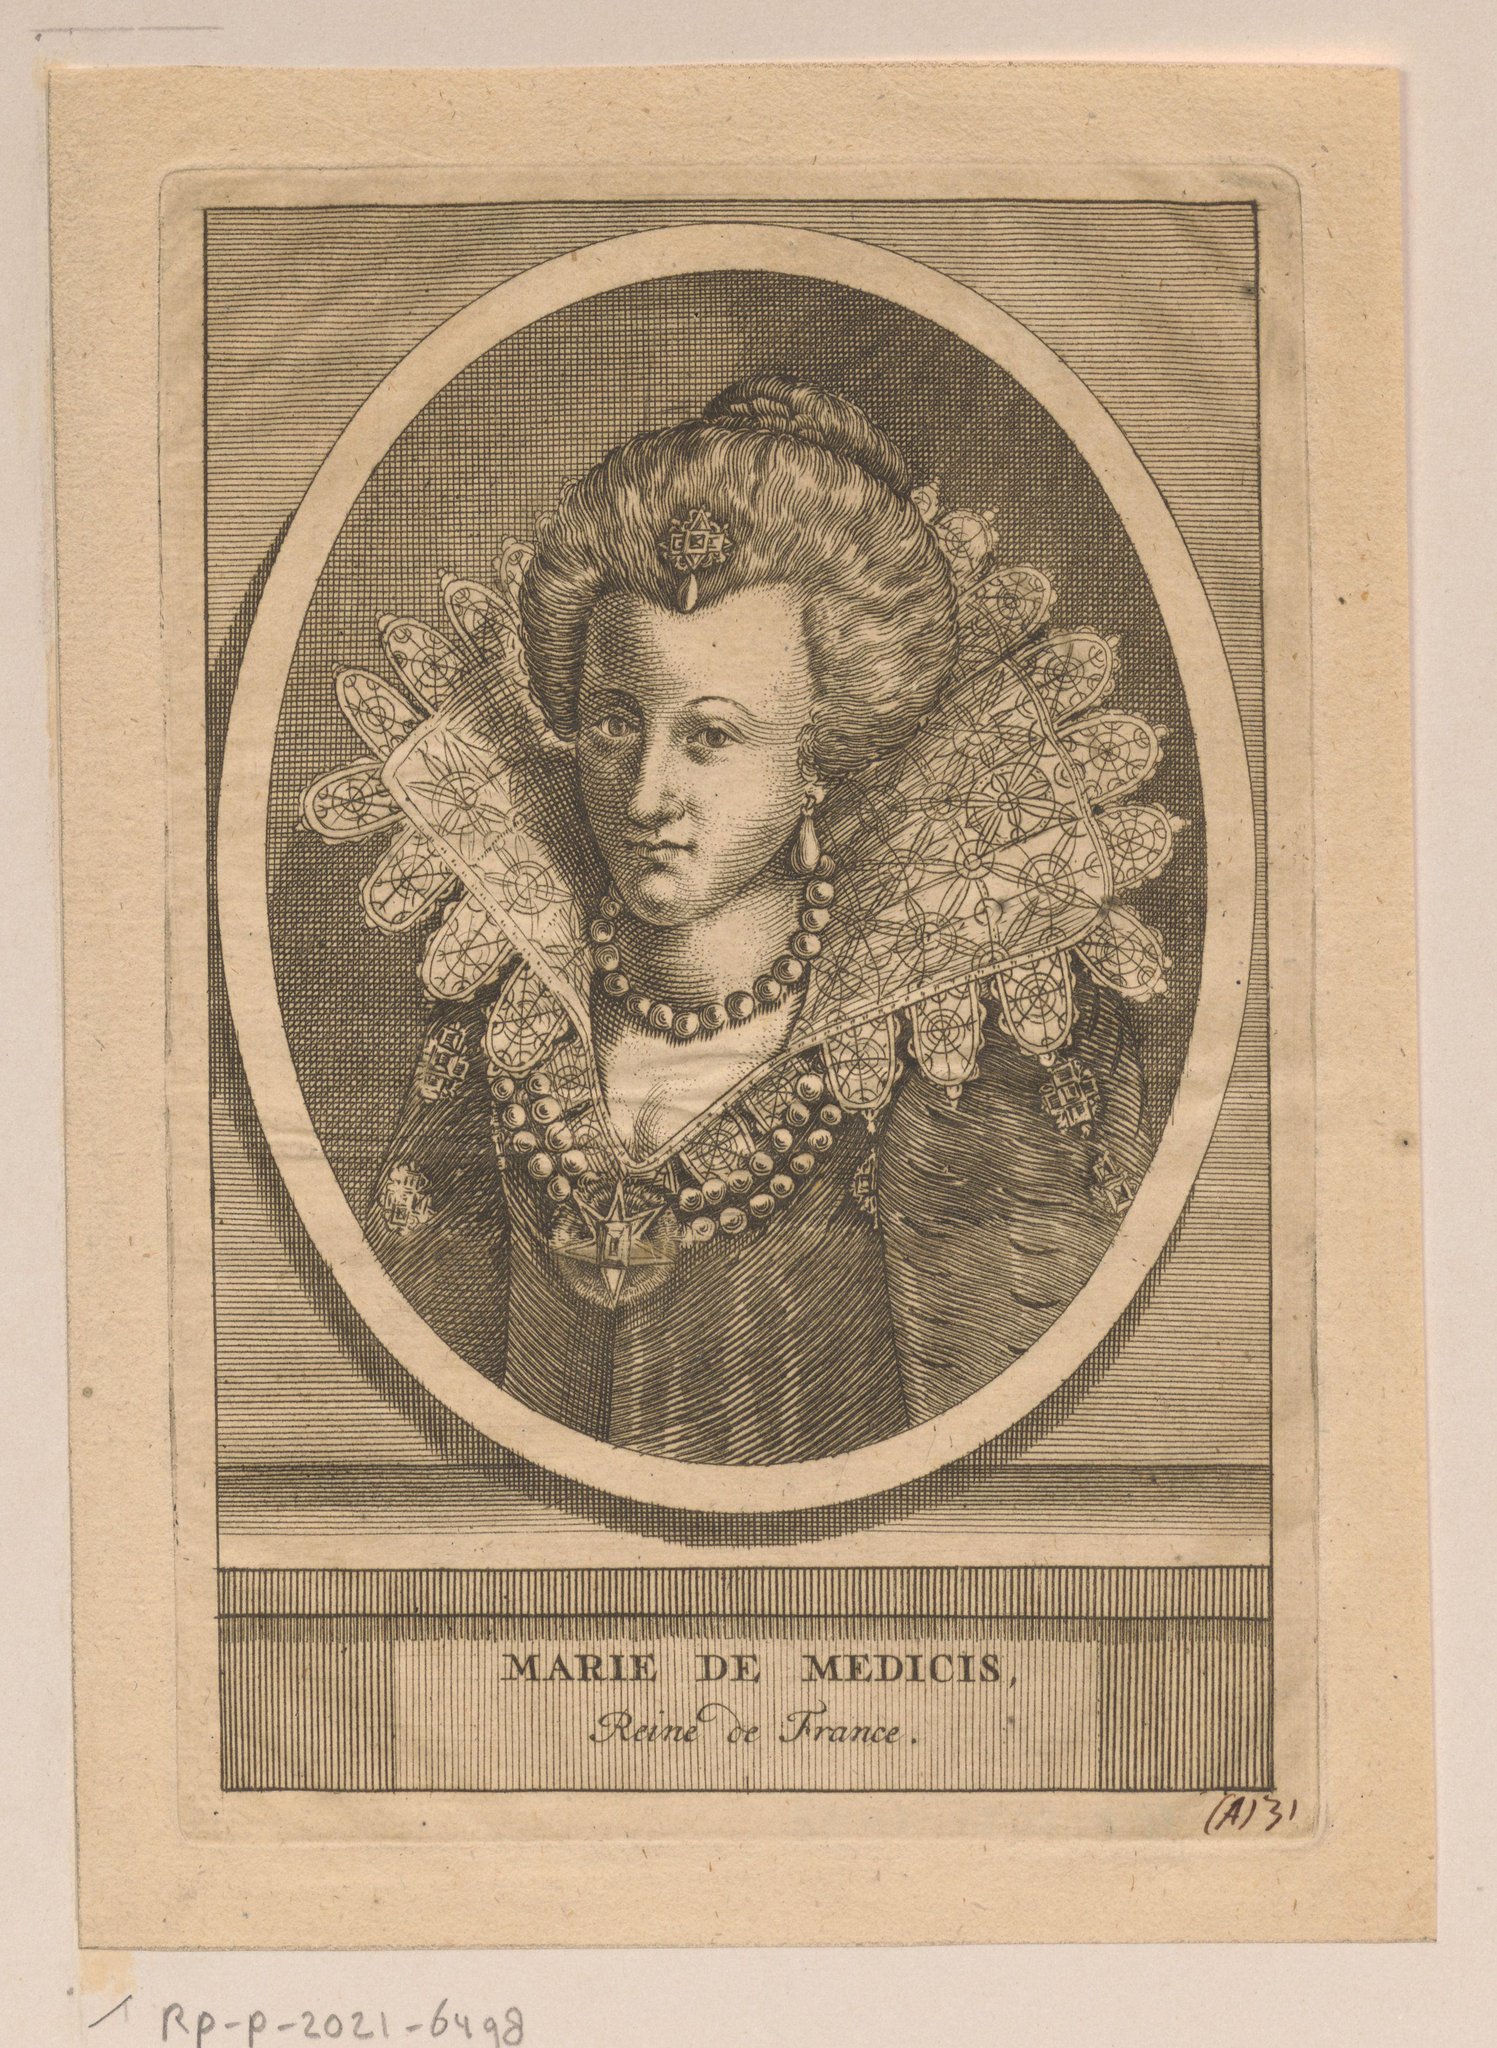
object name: print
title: Diverse portretten van pausen, keizers, koningen en andere belangrijke personen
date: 1729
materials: paper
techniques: engraving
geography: leiden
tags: print maker, maria de' medici, historical persons - bb - woman, ornament ~ medallion, queen, pearl; pearl necklace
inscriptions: number: ‘(A)31’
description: Rechtsonder handgeschreven genummerd: (A)31.